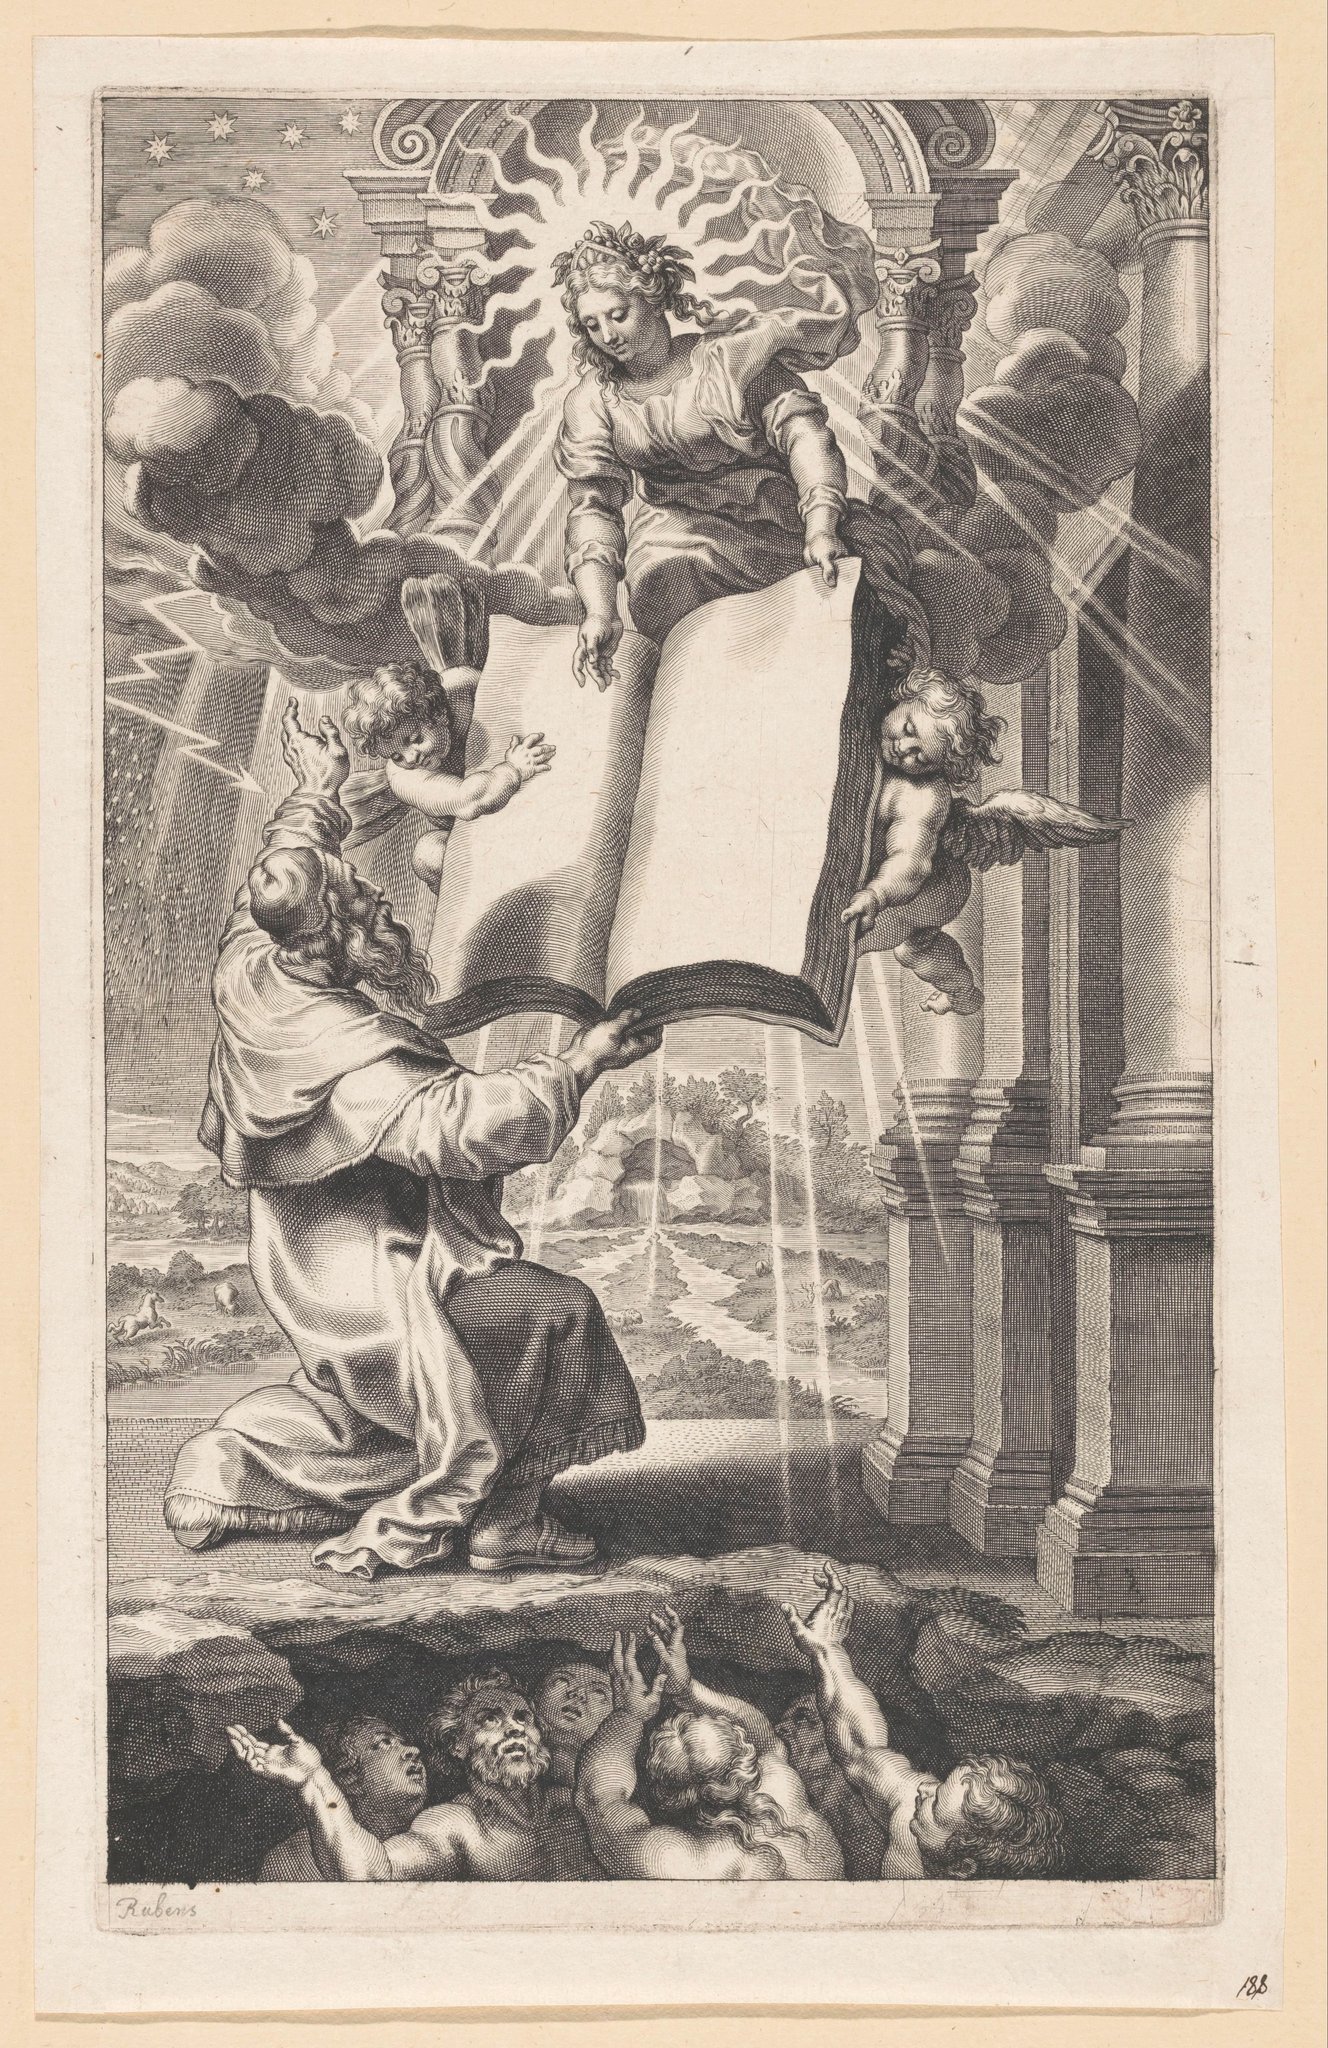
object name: titelblad, titelpagina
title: Jezus Sirach en de personificatie van Gods wijsheid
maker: cornelis galle (i)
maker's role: print maker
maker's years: 1576-1650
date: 1634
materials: paper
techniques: engraving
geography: southern netherlands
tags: title-page, 'sapientia', wisdom; 'sapienza divina' (ripa) ~ one of the seven gifts of the holy ghost, jesus sirach (not in biblical context)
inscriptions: collector's mark: Lugt 240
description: De personificatie van Gods wijsheid (Dei Sapientia) troont in de wolken en geeft een boek aan Jezus Sirach. Jezus Sirach knielt op de grond naast een gebouw met Korinthische zuilen. Naast hem zit een gat in de grond en is de onderwereld zichtbaar.